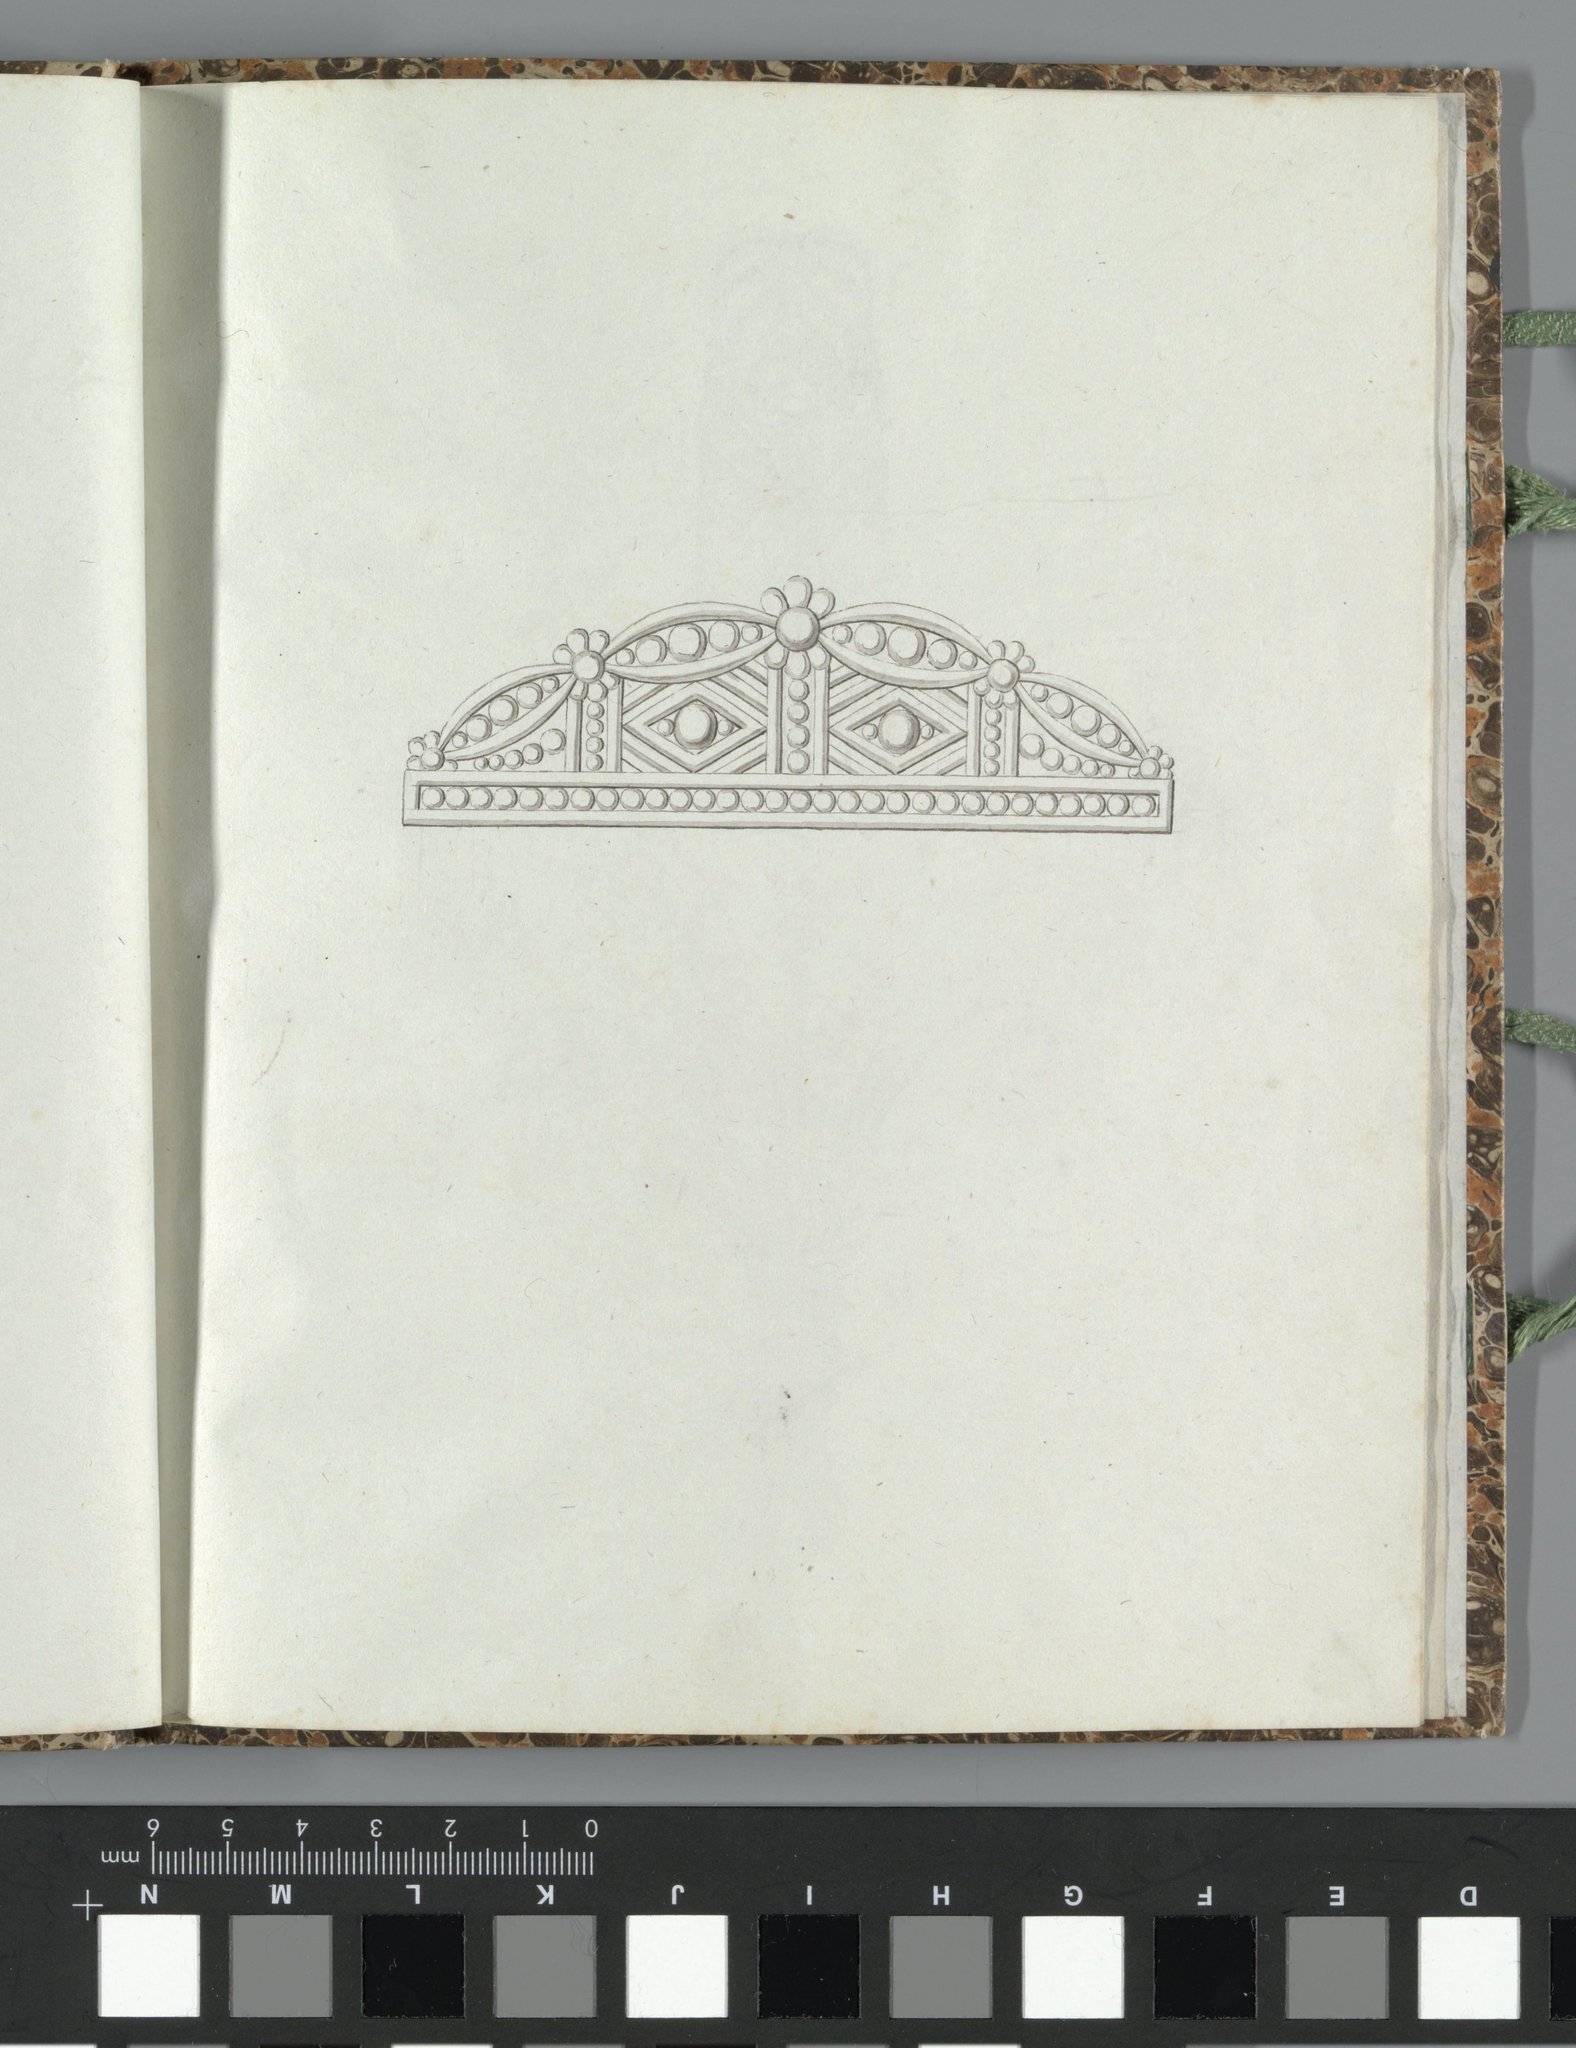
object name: sketchbook leaf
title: Ontwerp voor een juweel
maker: carl friedrich bärthel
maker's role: draughtsman, jeweler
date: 1800-1810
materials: ink, paper, watercolor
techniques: brush, pen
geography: augsburg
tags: ornaments, jewels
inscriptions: watermark